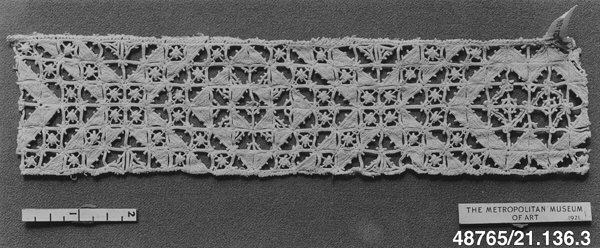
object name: piece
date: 1600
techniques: lace